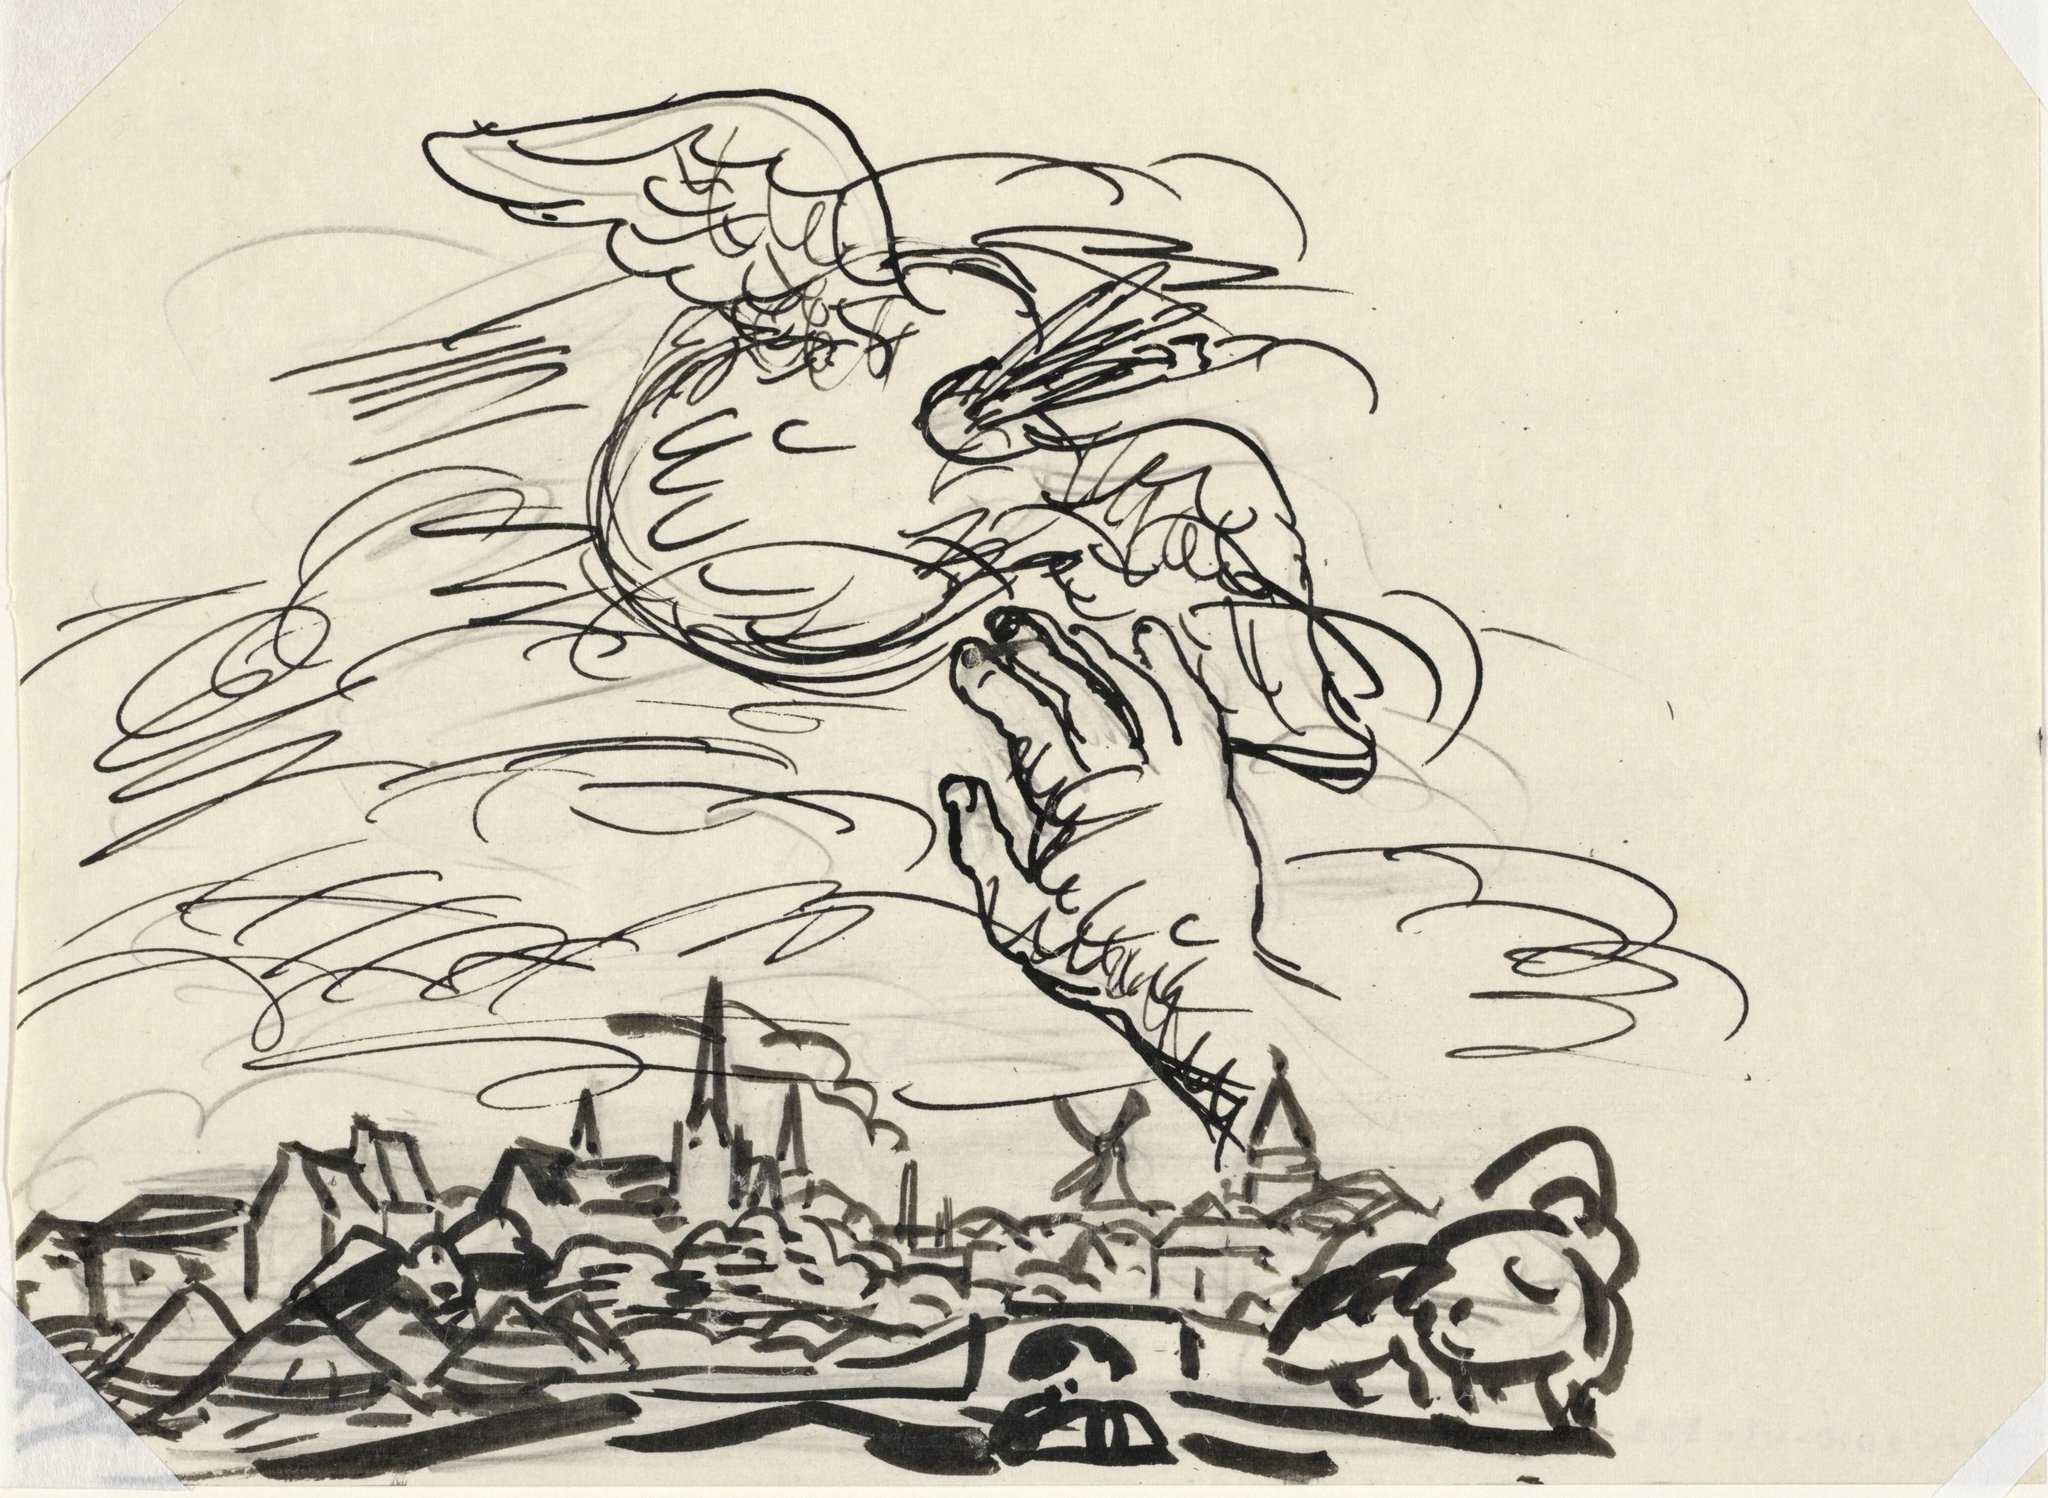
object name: drawing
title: Zonder titel Schets gezicht op Woerden met hand en vliegend palet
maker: leo gestel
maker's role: draughtsman, print maker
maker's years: 1881-1941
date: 1935-1936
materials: ink, paper, pencil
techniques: brush, pen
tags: city-view in general; 'veduta', palette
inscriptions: inscription: ‘Jeugd Woerden / Schets’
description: De huidige titels zijn door het museum toegekend bij gebrek aan informatie over een originele titel.